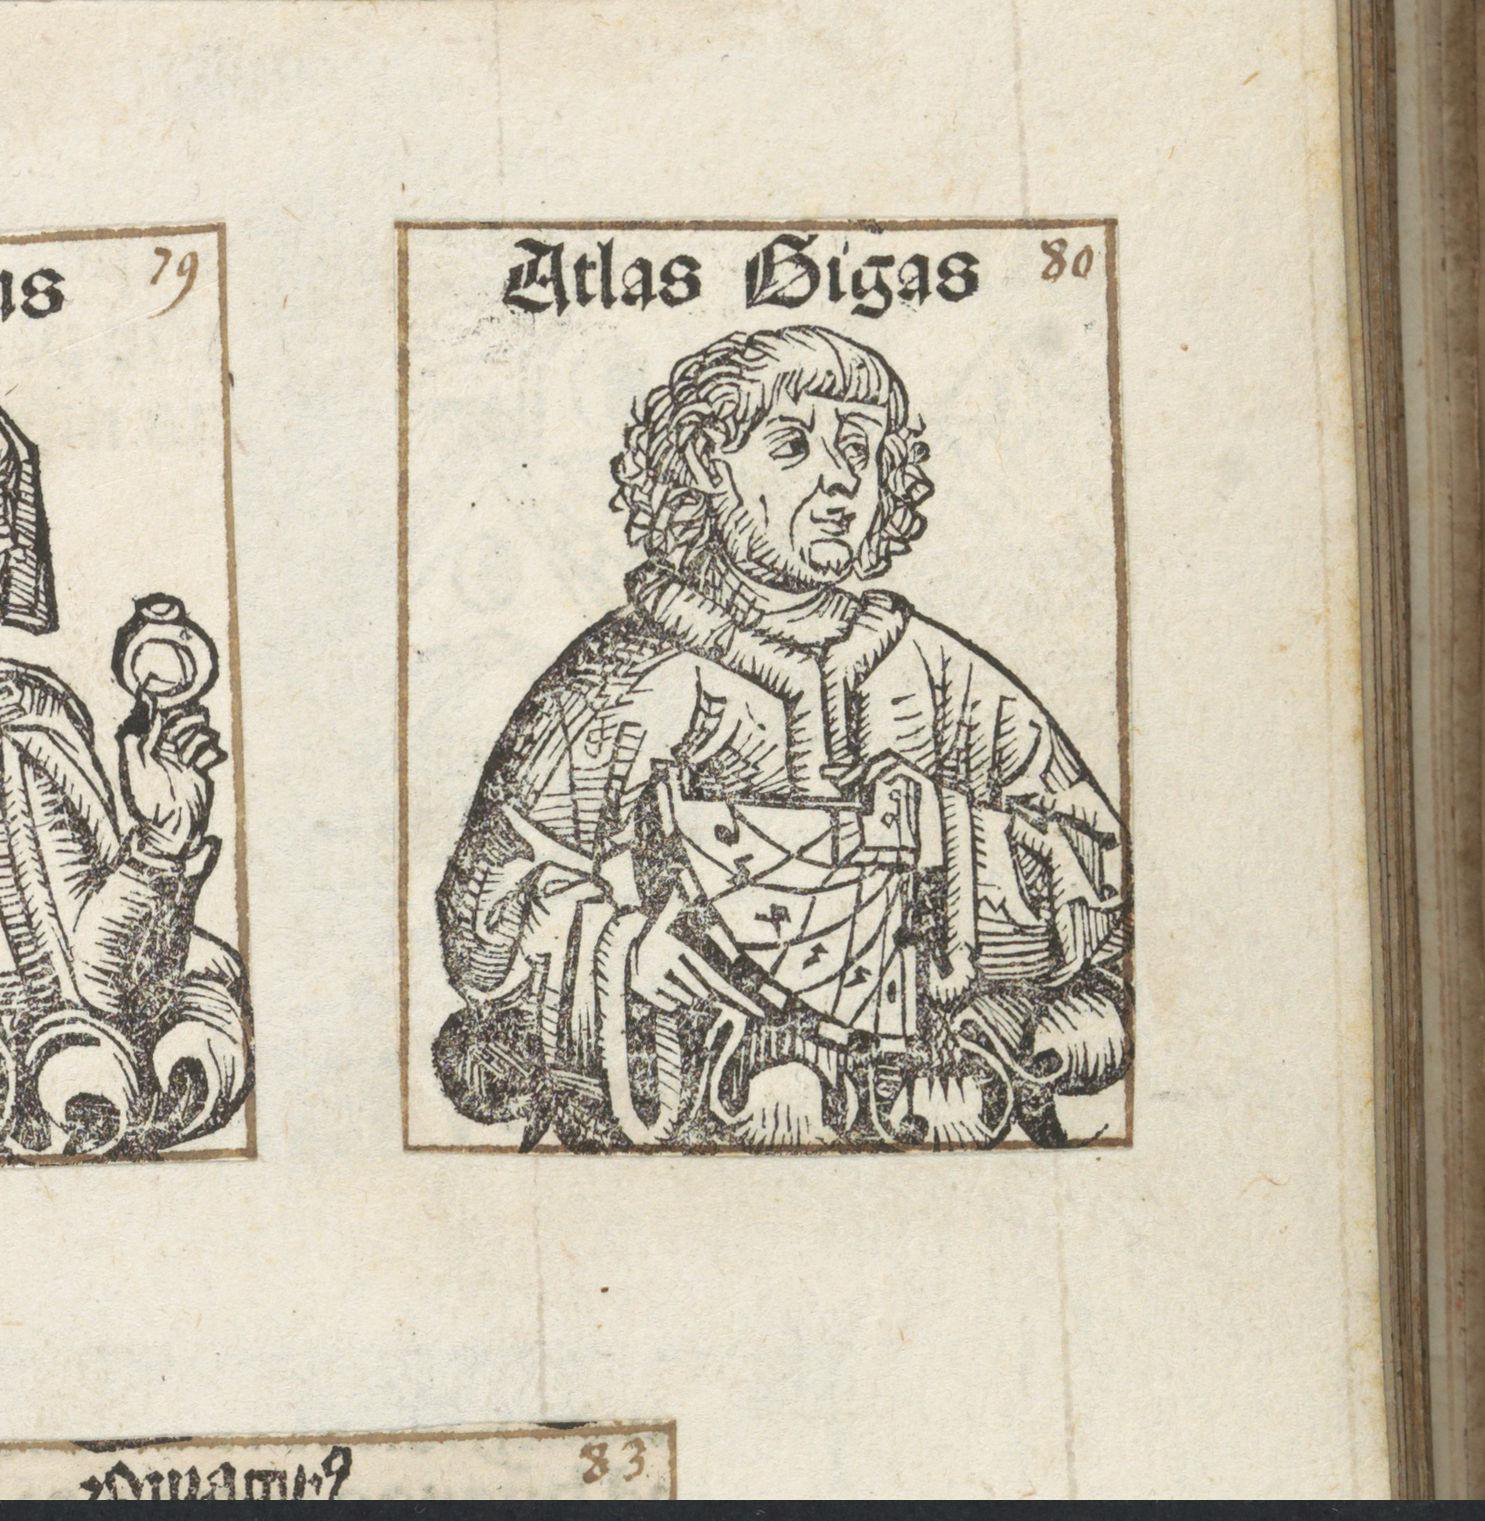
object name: print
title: Liber Chronicarum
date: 1493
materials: paper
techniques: letterpress printing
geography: nuremberg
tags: (story of) atlas - attributes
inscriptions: inscription: ‘80’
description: De houtsnede wordt gebruikt als boekillustratie in de Liber Chronicarum (of Neurenbergkroniek) van Hartmann Schedel, verschenen in het Latijn en Duits in 1493. Zie de Latijnse uitgave, folio 28r.